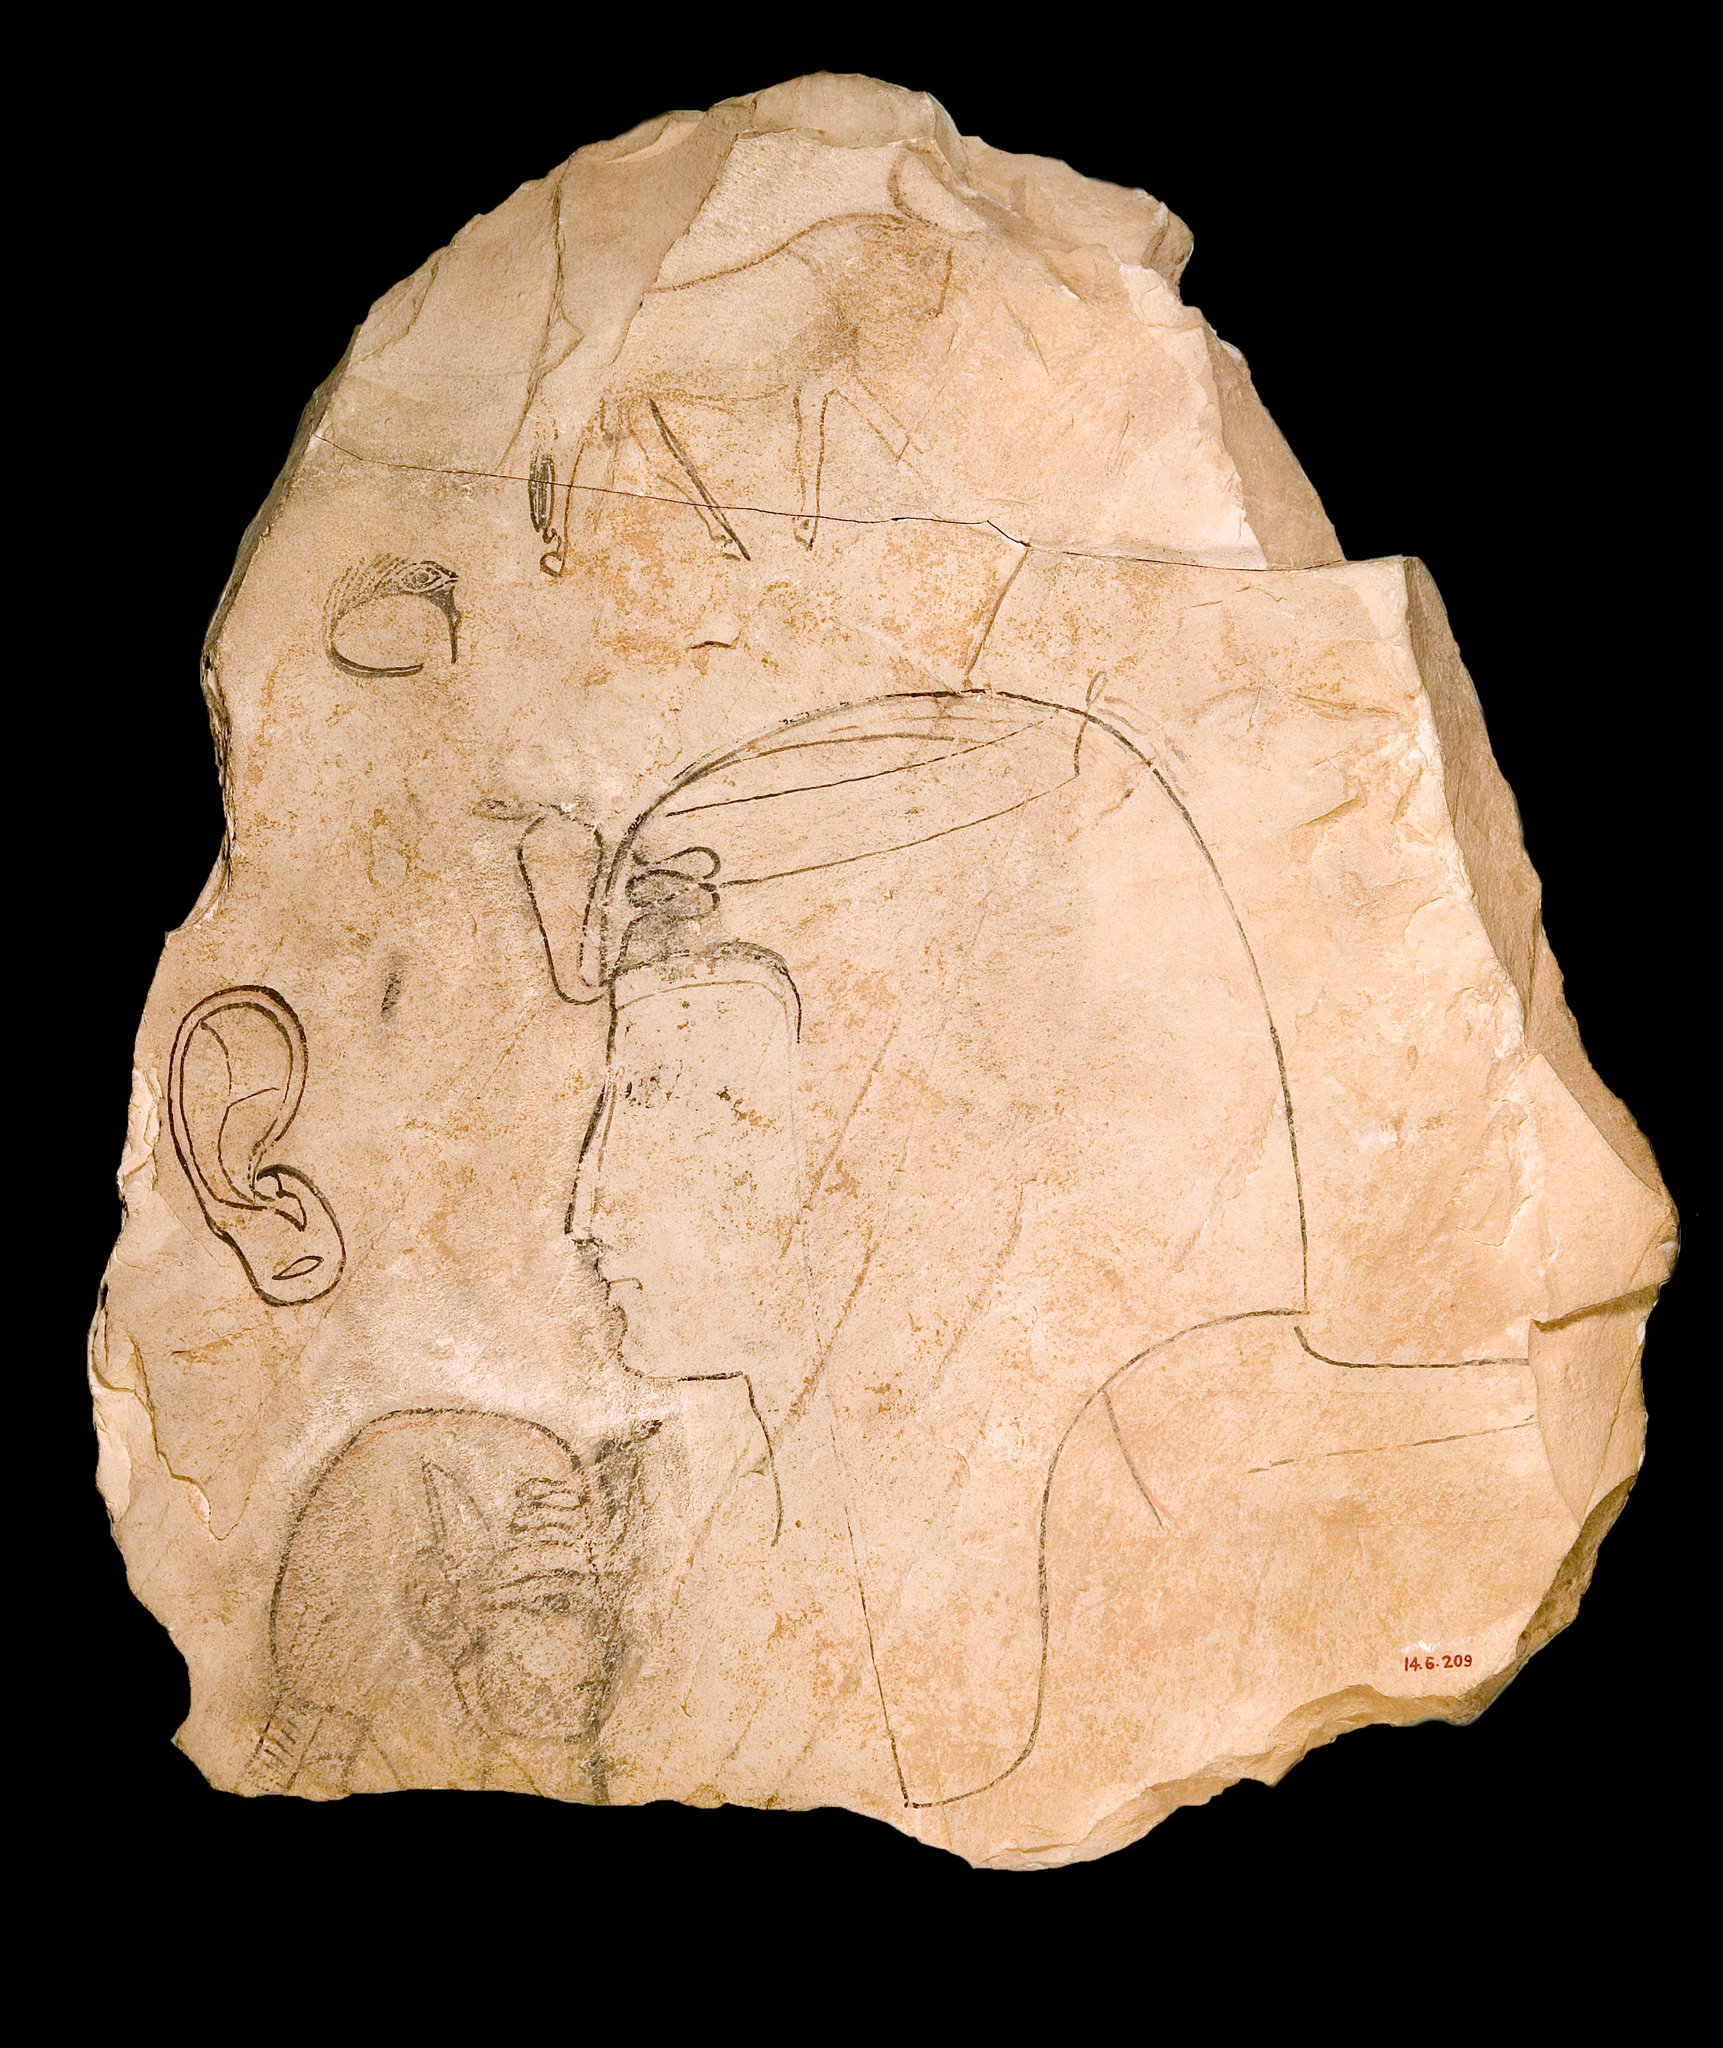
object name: ostracon, figured, king, bull, ear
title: Ostracon With a Royal Head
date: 1295-1070 BCE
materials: ink, limestone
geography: egypt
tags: heads,men,bulls